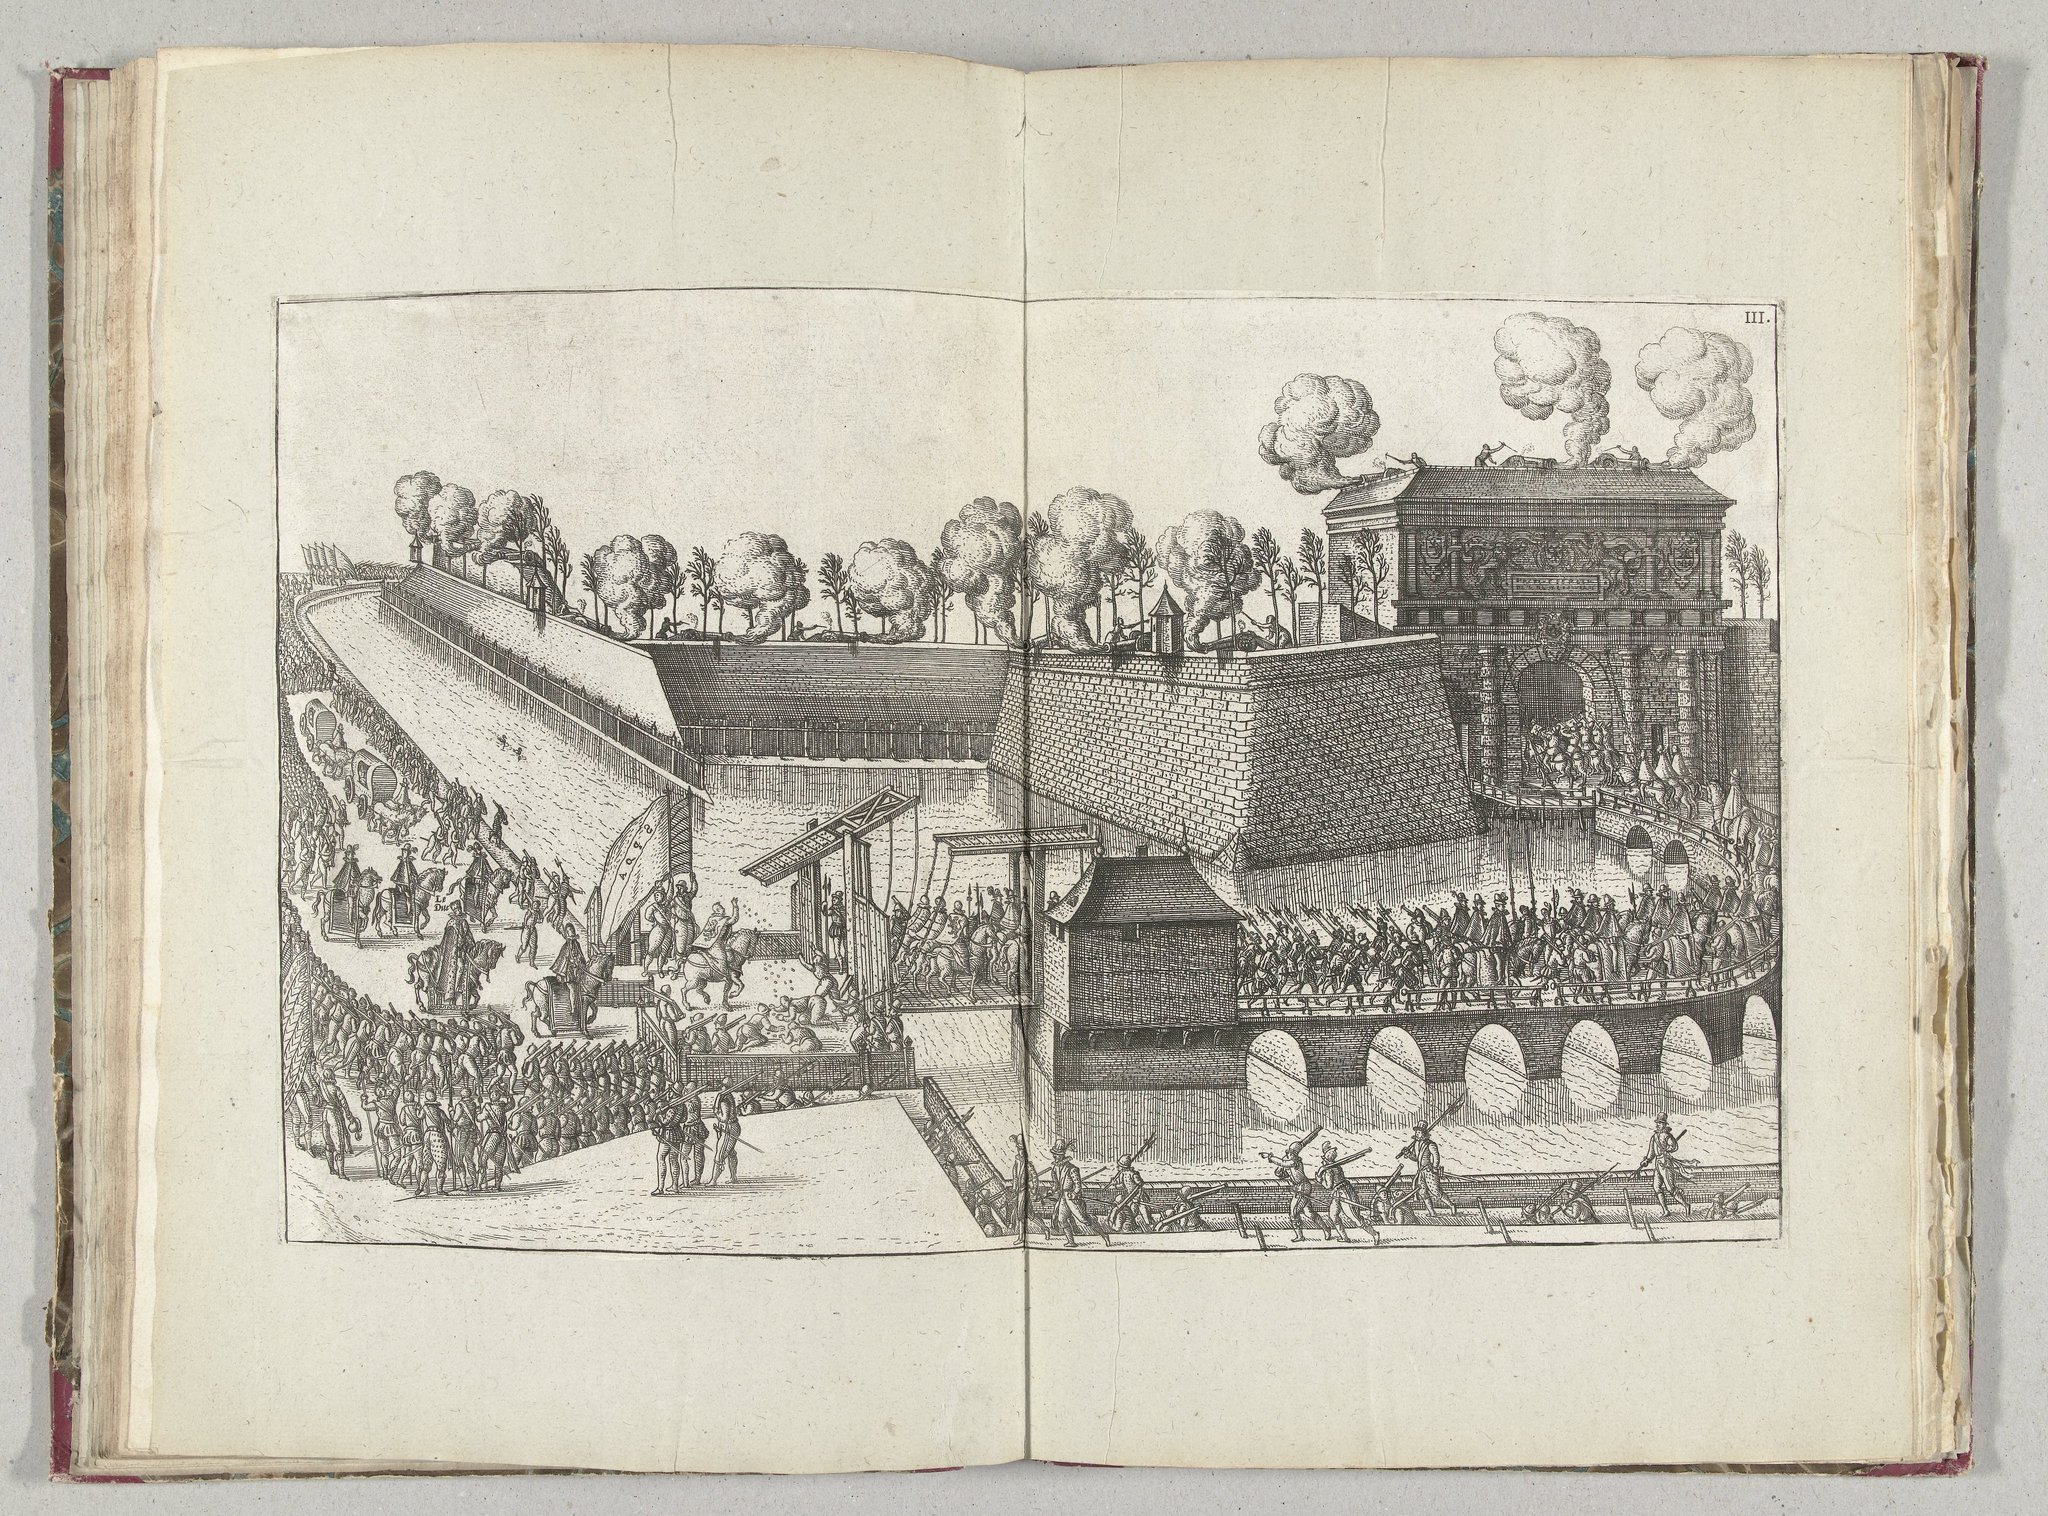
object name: print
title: De stoet trekt door de Keizerspoort de stad binnen, 1582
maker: Anonymous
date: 1582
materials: paper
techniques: etching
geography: netherlands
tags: françois-hercule de valois (hertog van anjou), coins specially minted for the occasion (triumphal entry, etc.) (dutch: 'strooipenningen'), triumphal entry and public reception, pageant, 'entrée solennelle', 'joyeuse entrée'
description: Illustratie in: La ioyeuse et magnifique entrée de Françoys ... Duc de Brabant, d'Anjou, Alençon, Berri et c. en sa tres-renommée ville d'Anvers, Christoffel Plantijn, Antwerpen 1582, pl. III. Boek in de Rijksmuseum Research Library met signatuur: 327 I 8.